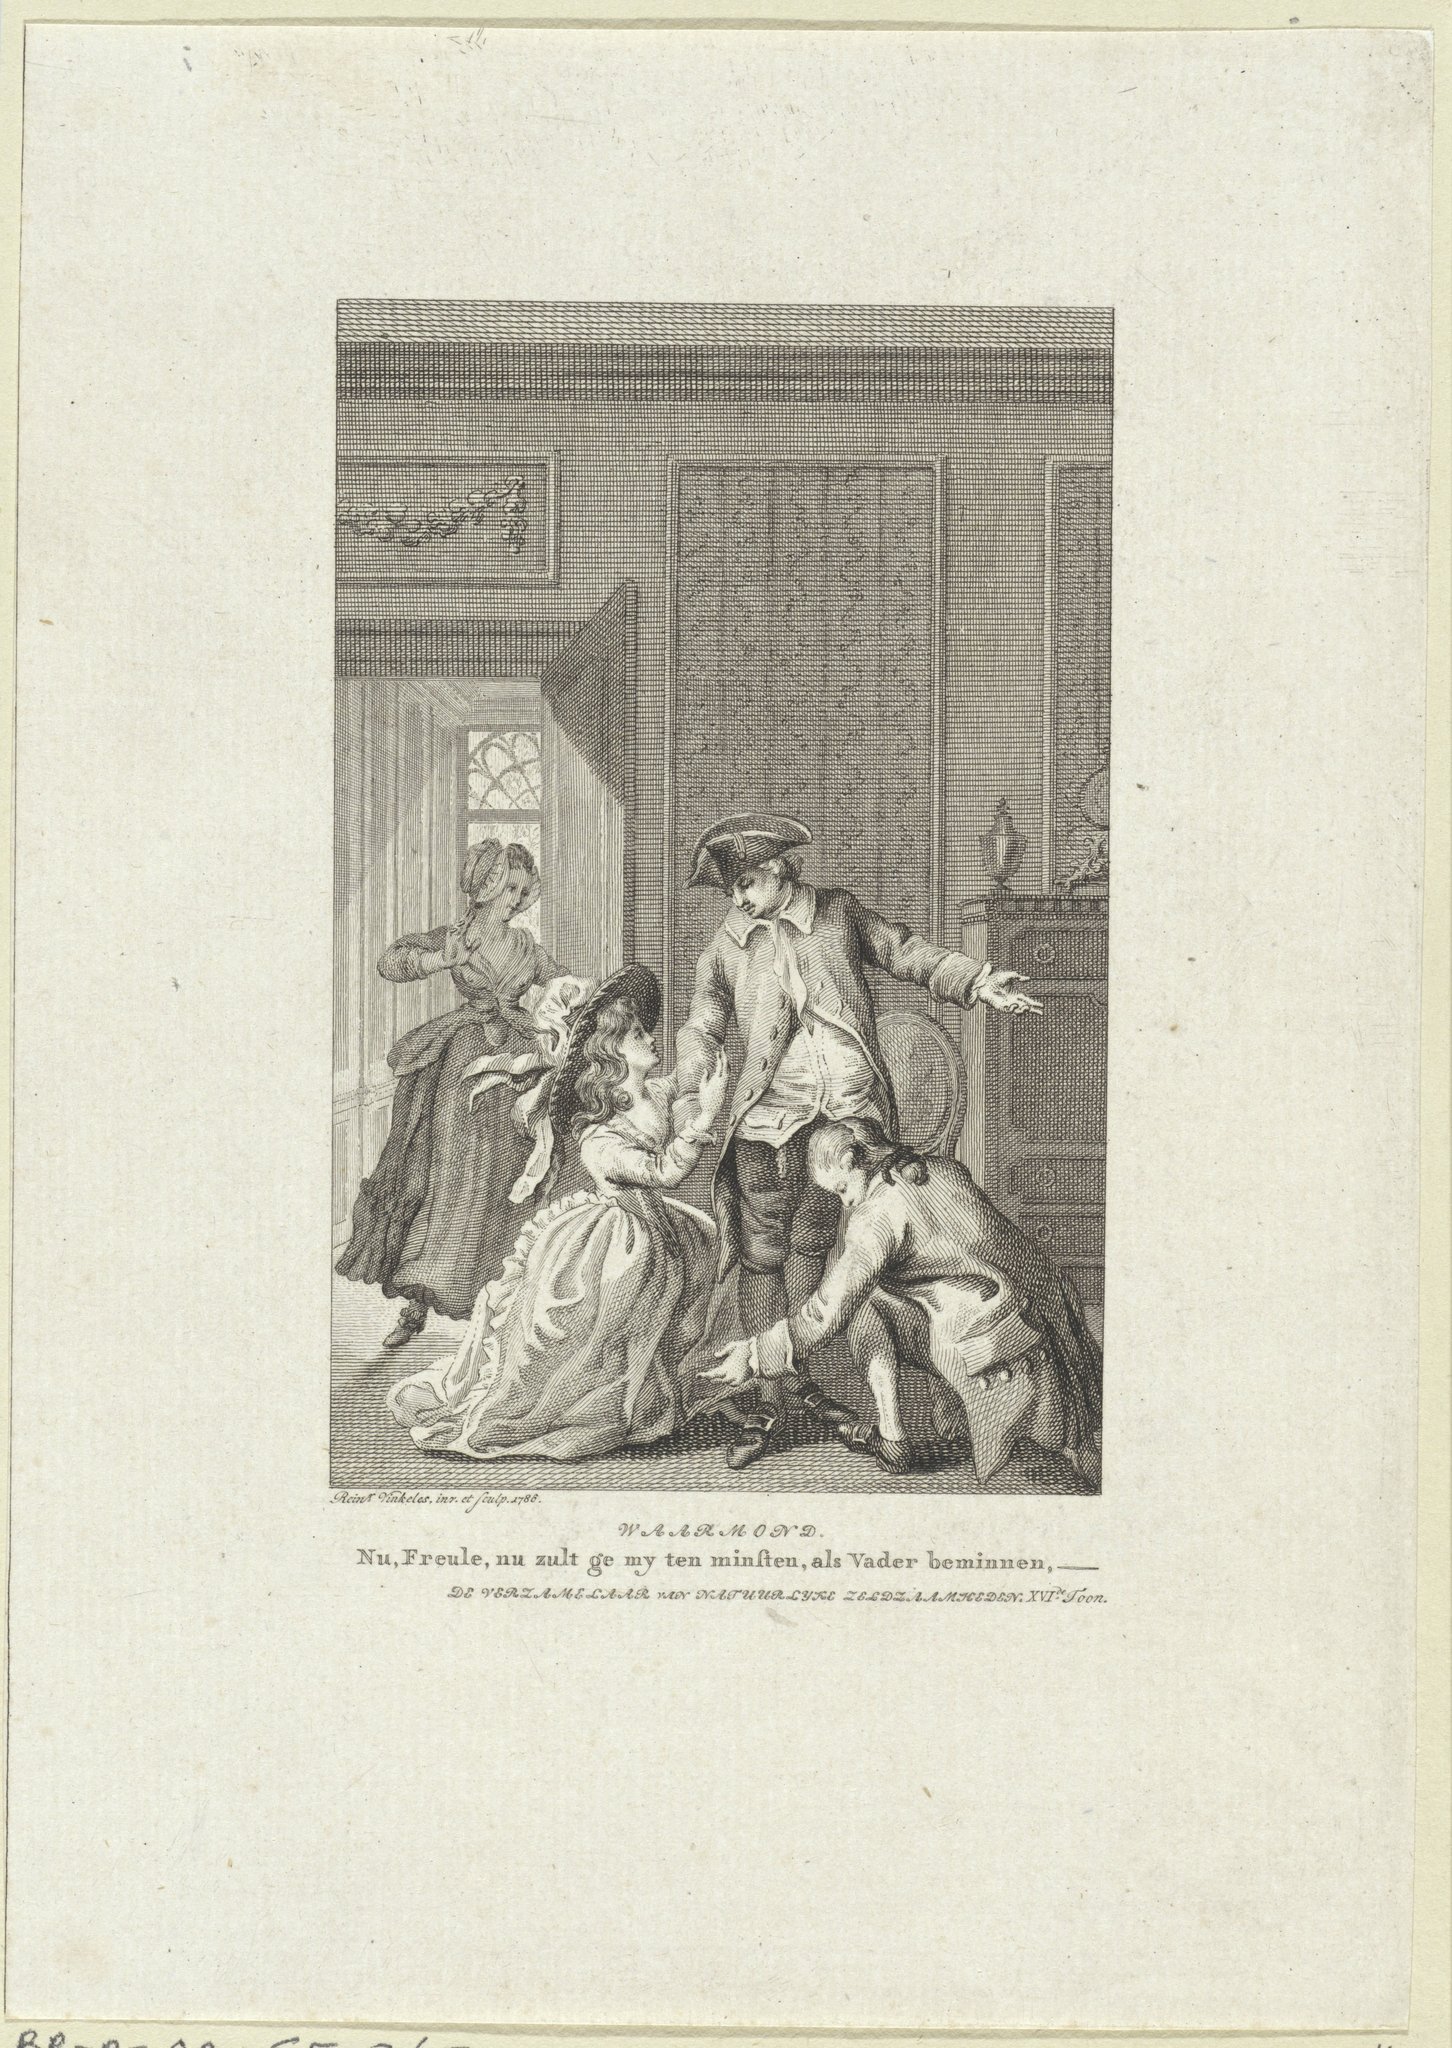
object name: print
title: Man en een vrouw knielen aan de voeten van een heer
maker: reinier vinkeles (i)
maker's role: draughtsman, print maker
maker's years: 1741-1816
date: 1786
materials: paper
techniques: engraving, etching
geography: amsterdam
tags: kneeling figure, couple of lovers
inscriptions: collector's mark: Lugt 240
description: Deze prent is mogelijk gebruikt als illustratie voor: De onverwagte ontmoeting, of De verzamelaar van natuurlyke zeldzaamheden. Amsterdam: Erven Pieter Meĳer en Gerrit Warnars, 1786.